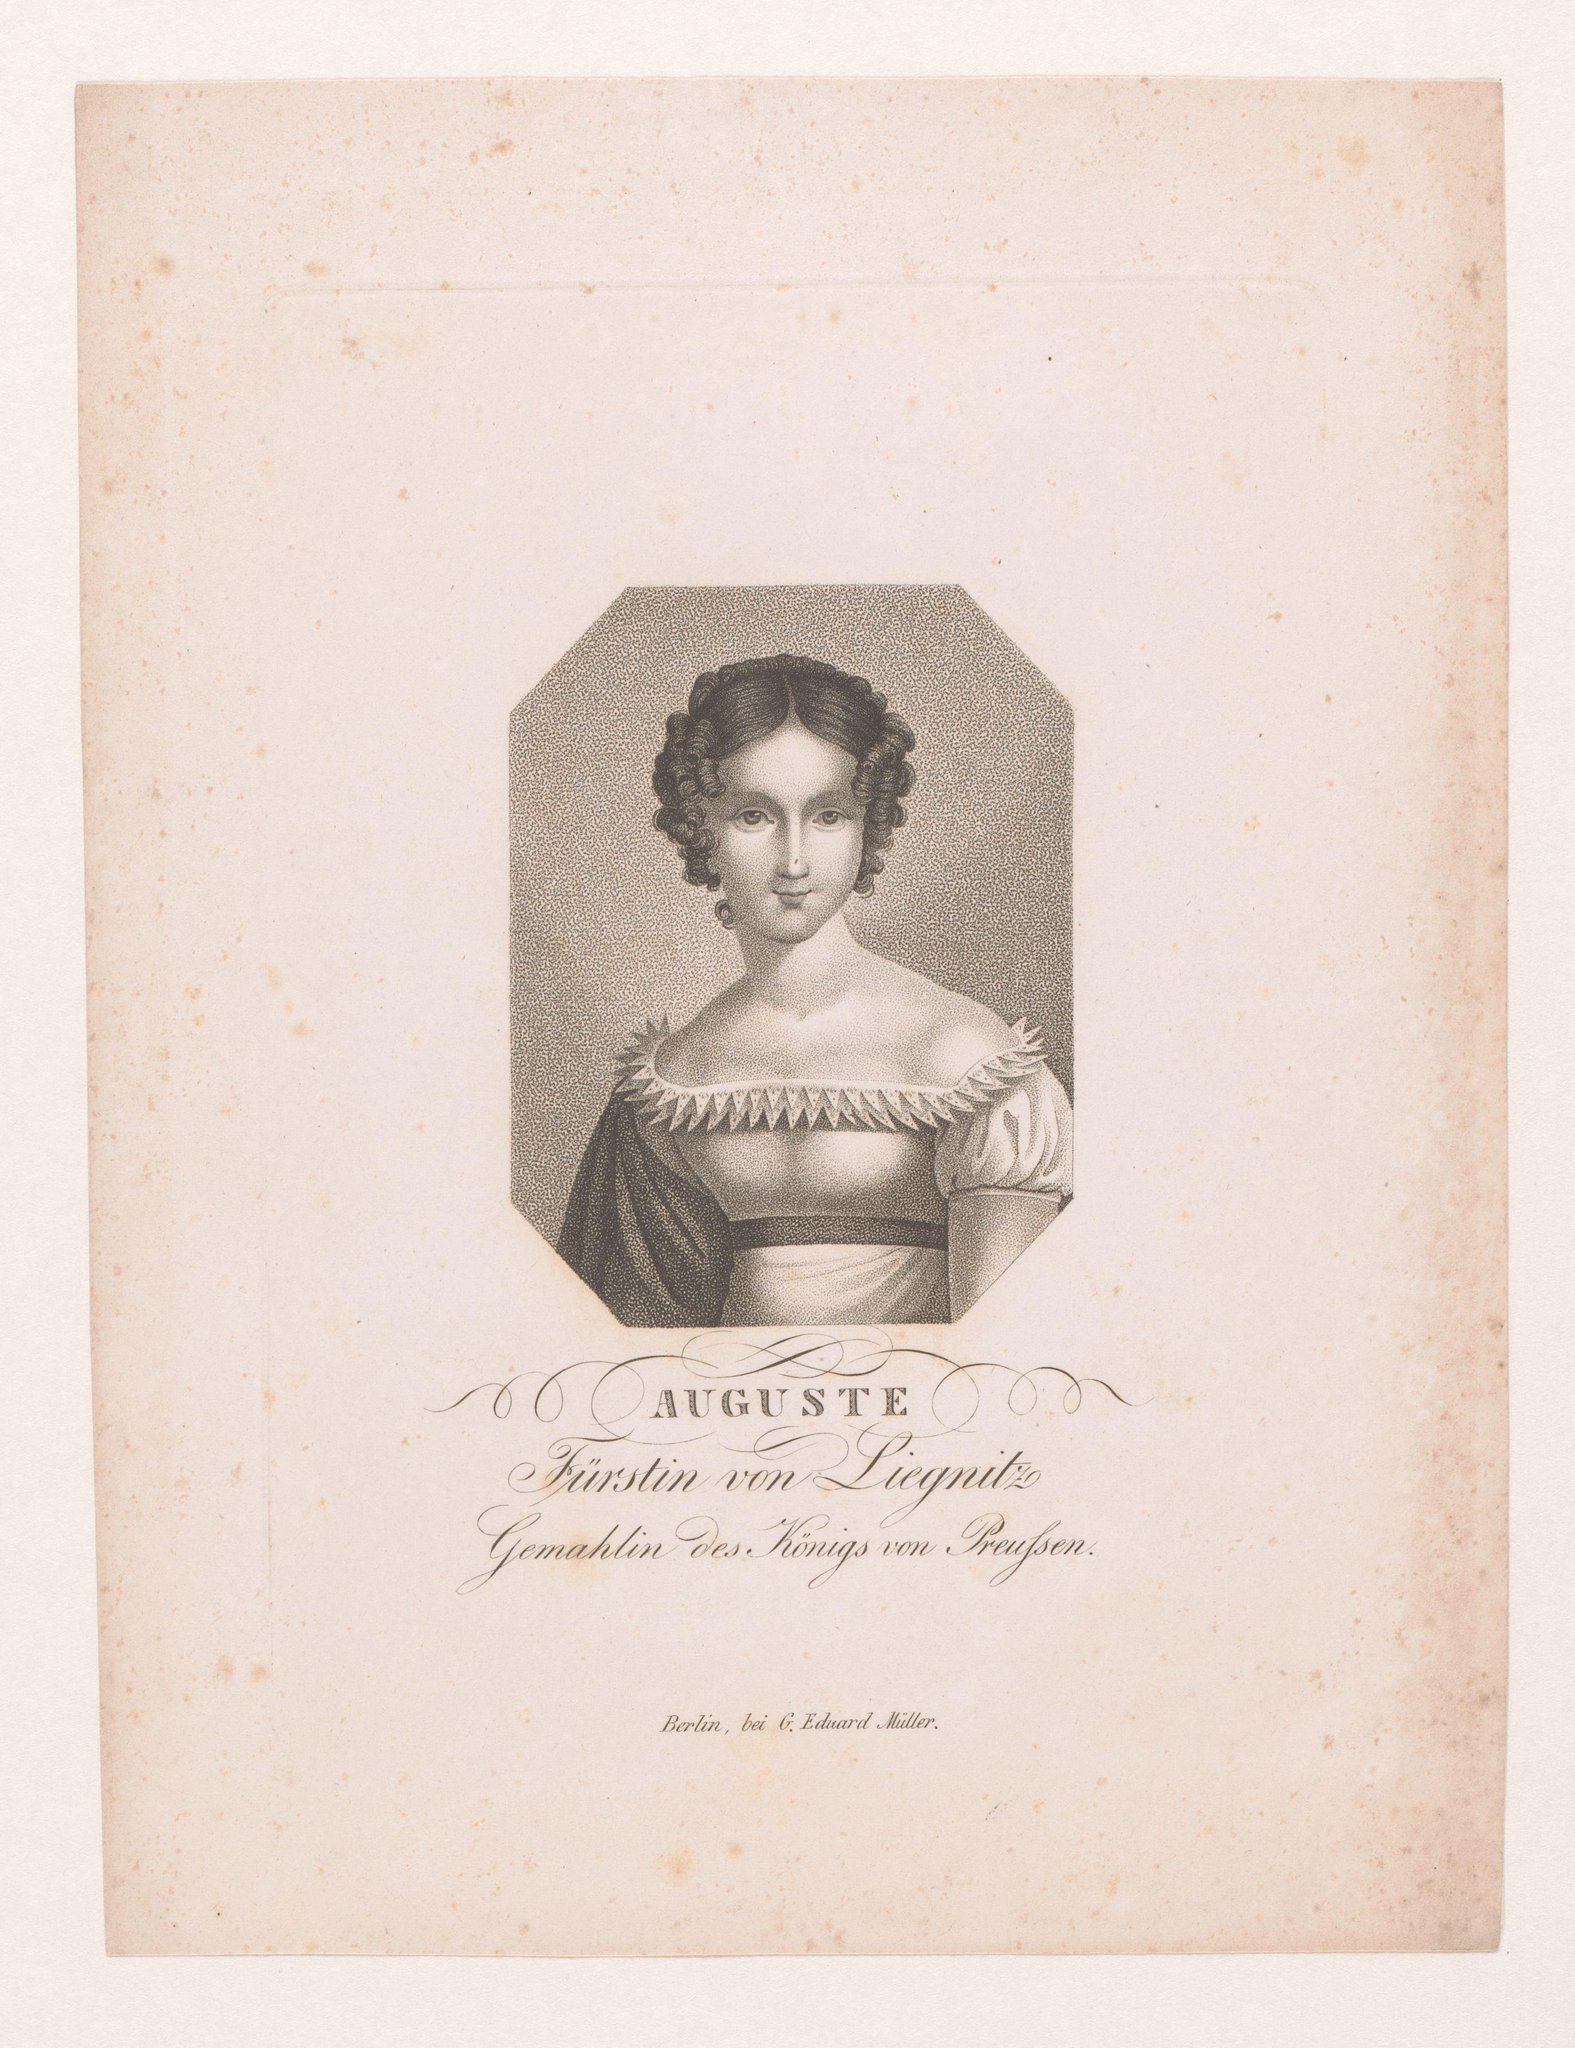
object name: print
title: Portret van Auguste von Liegnitz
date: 1810-1844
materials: paper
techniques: stippling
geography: berlin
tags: historical persons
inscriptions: collector's mark: Lugt 2228